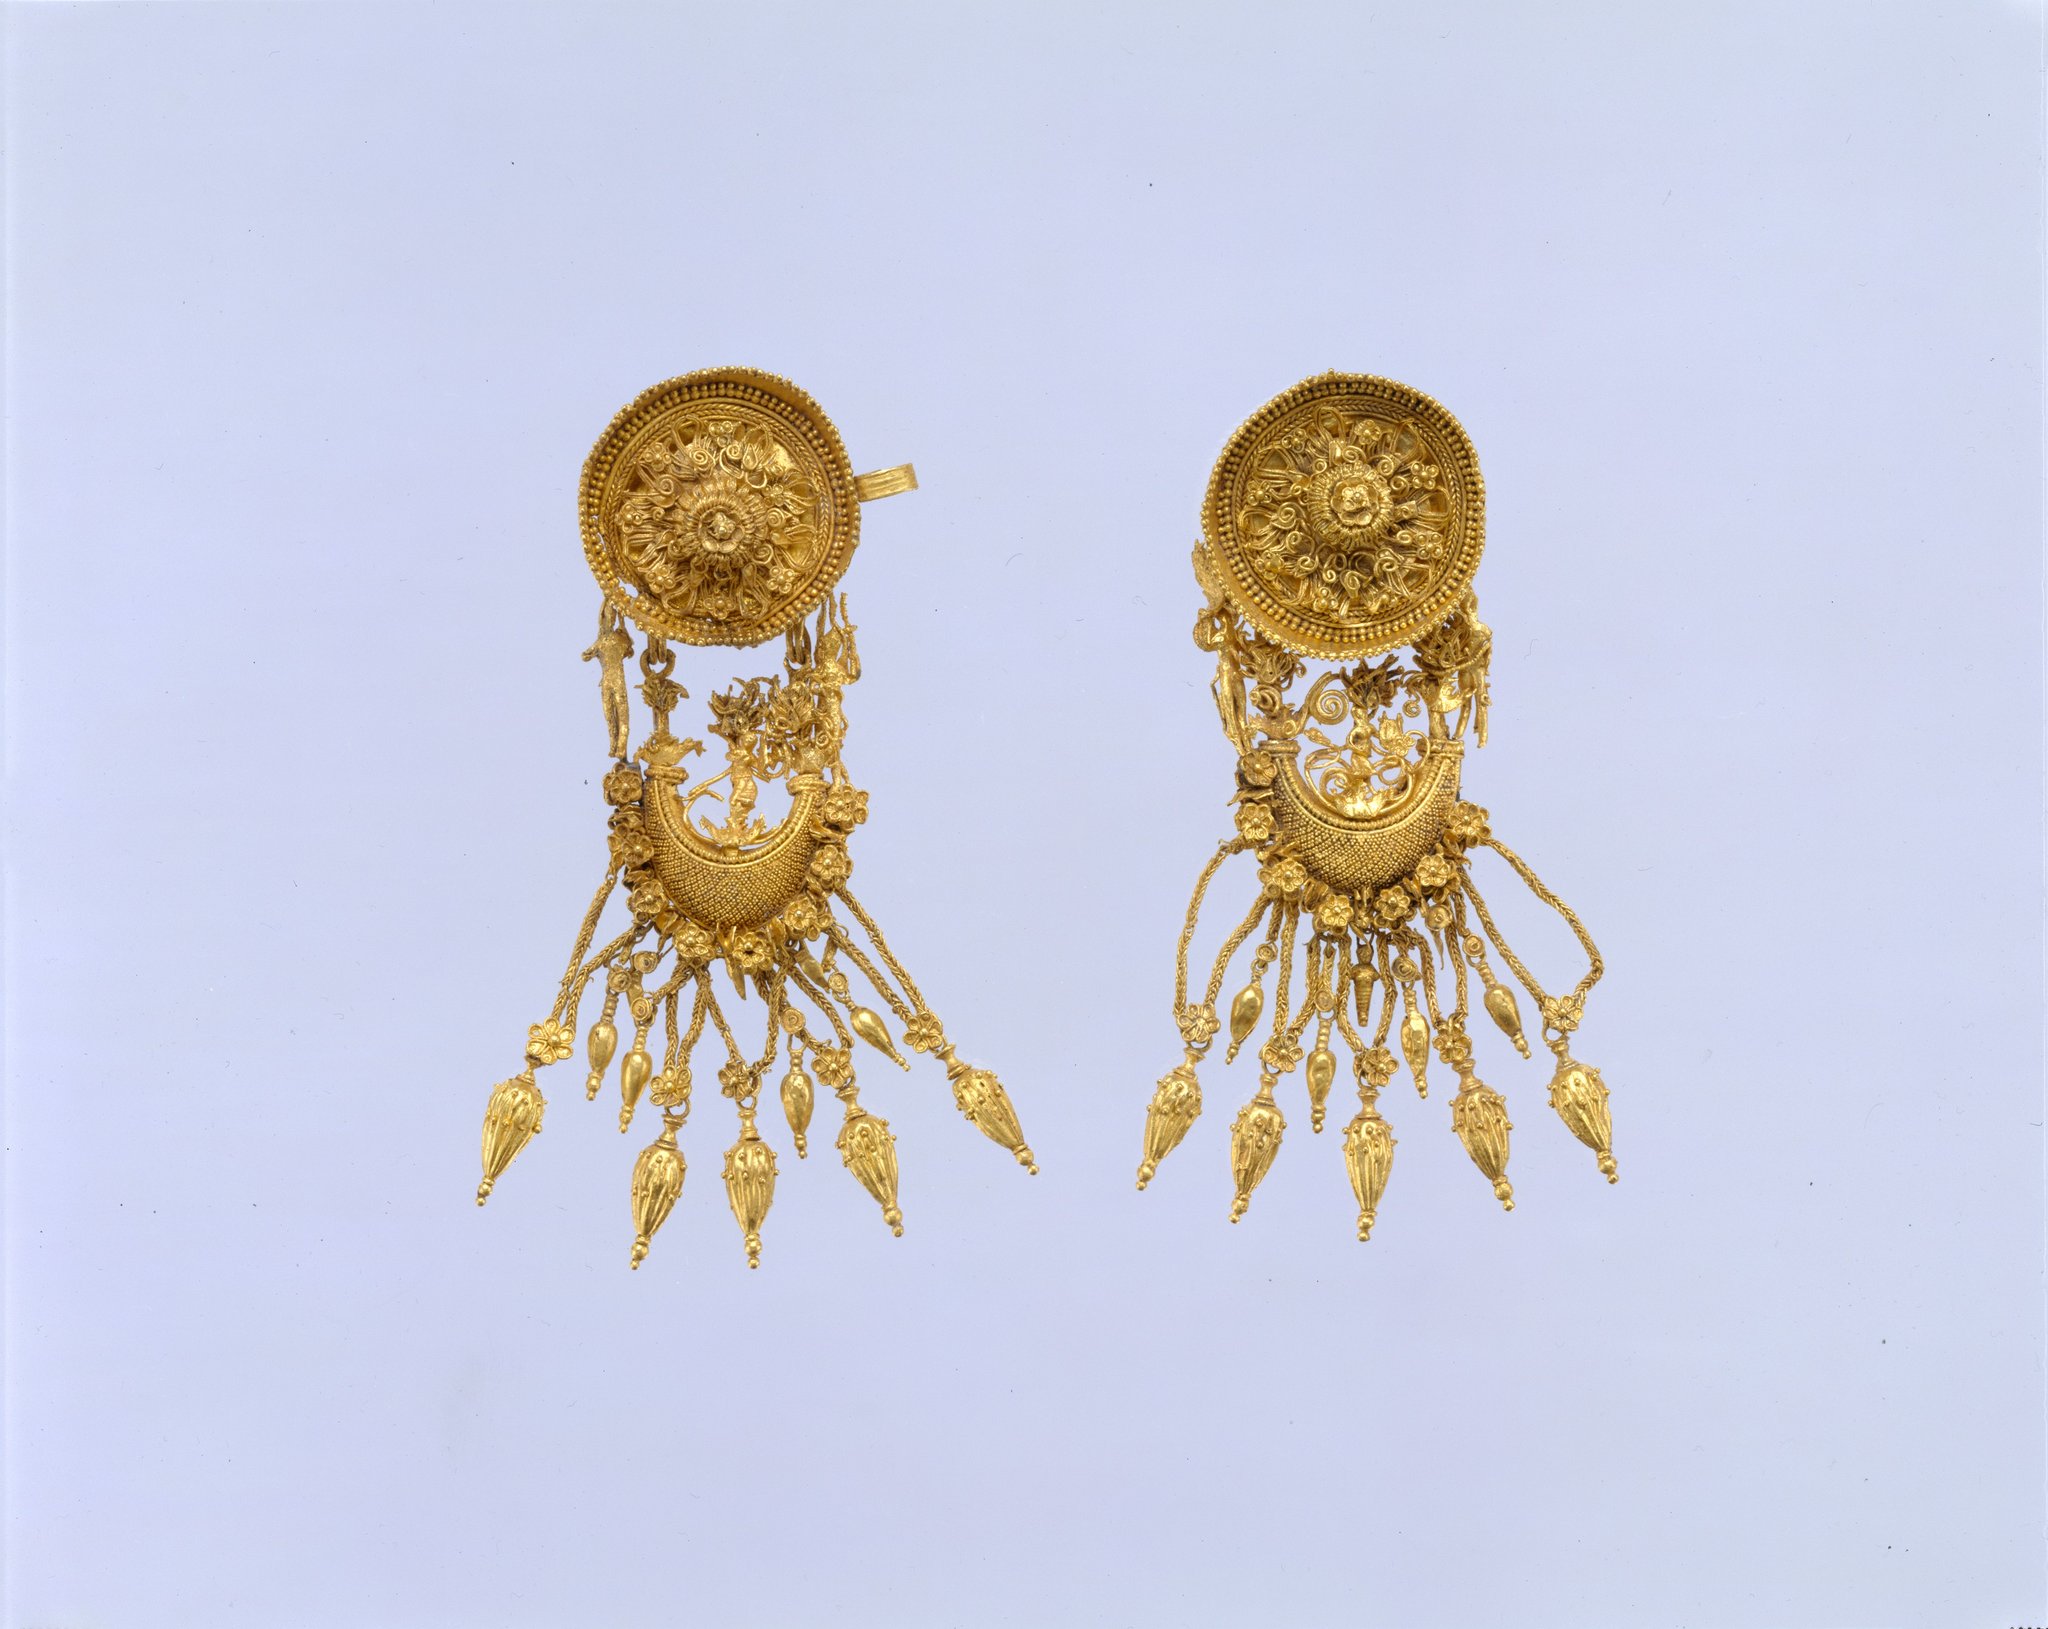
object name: earring with disc and boat shaped pendant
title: Pair of gold earrings with disk and boat-shaped pendant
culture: greek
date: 330-300 BCE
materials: gold